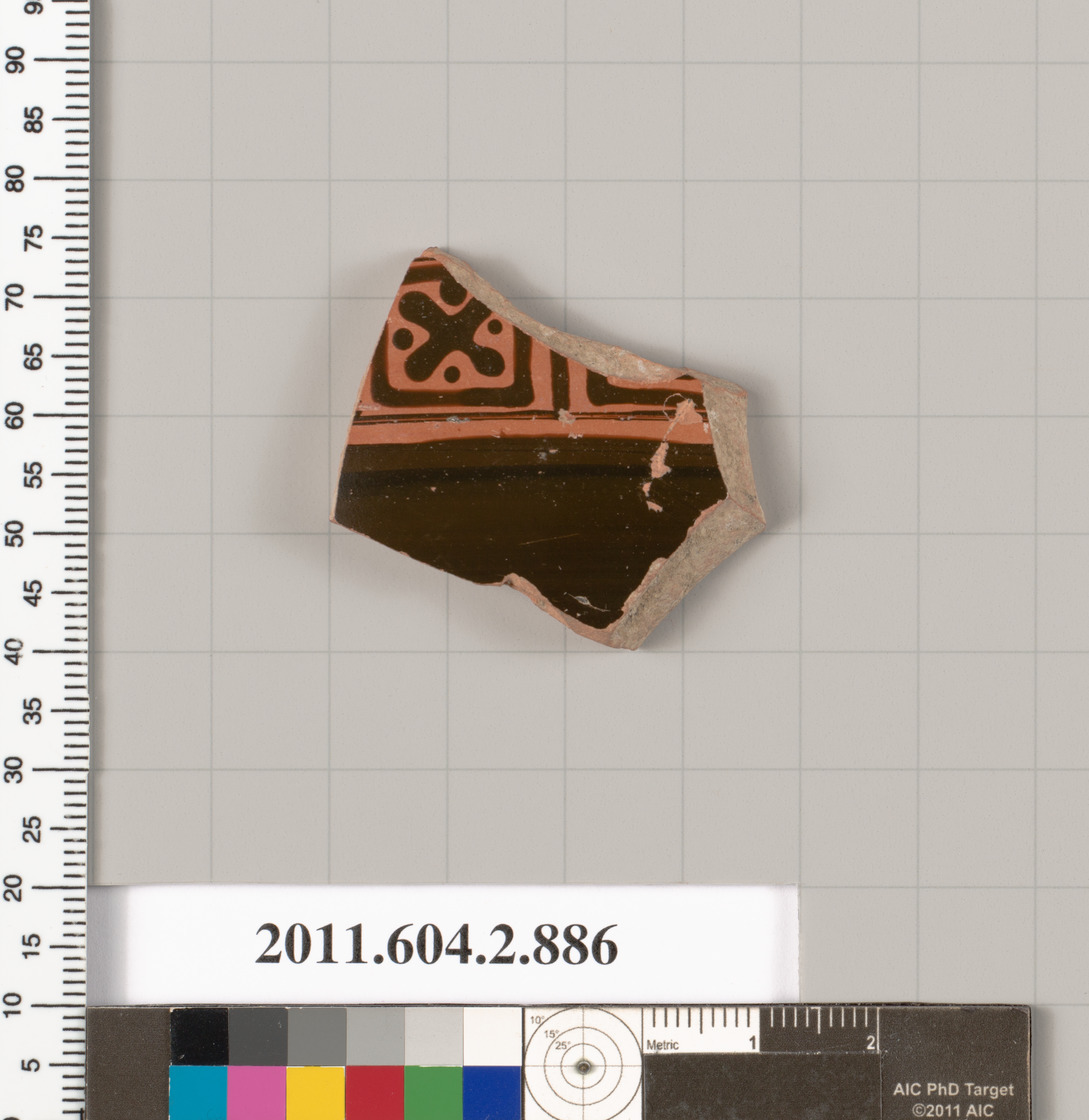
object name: bell krater fragment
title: Terracotta fragment of a bell-krater (bowl for mixing wine and water)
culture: greek, attic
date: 470-460 BCE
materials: terracotta